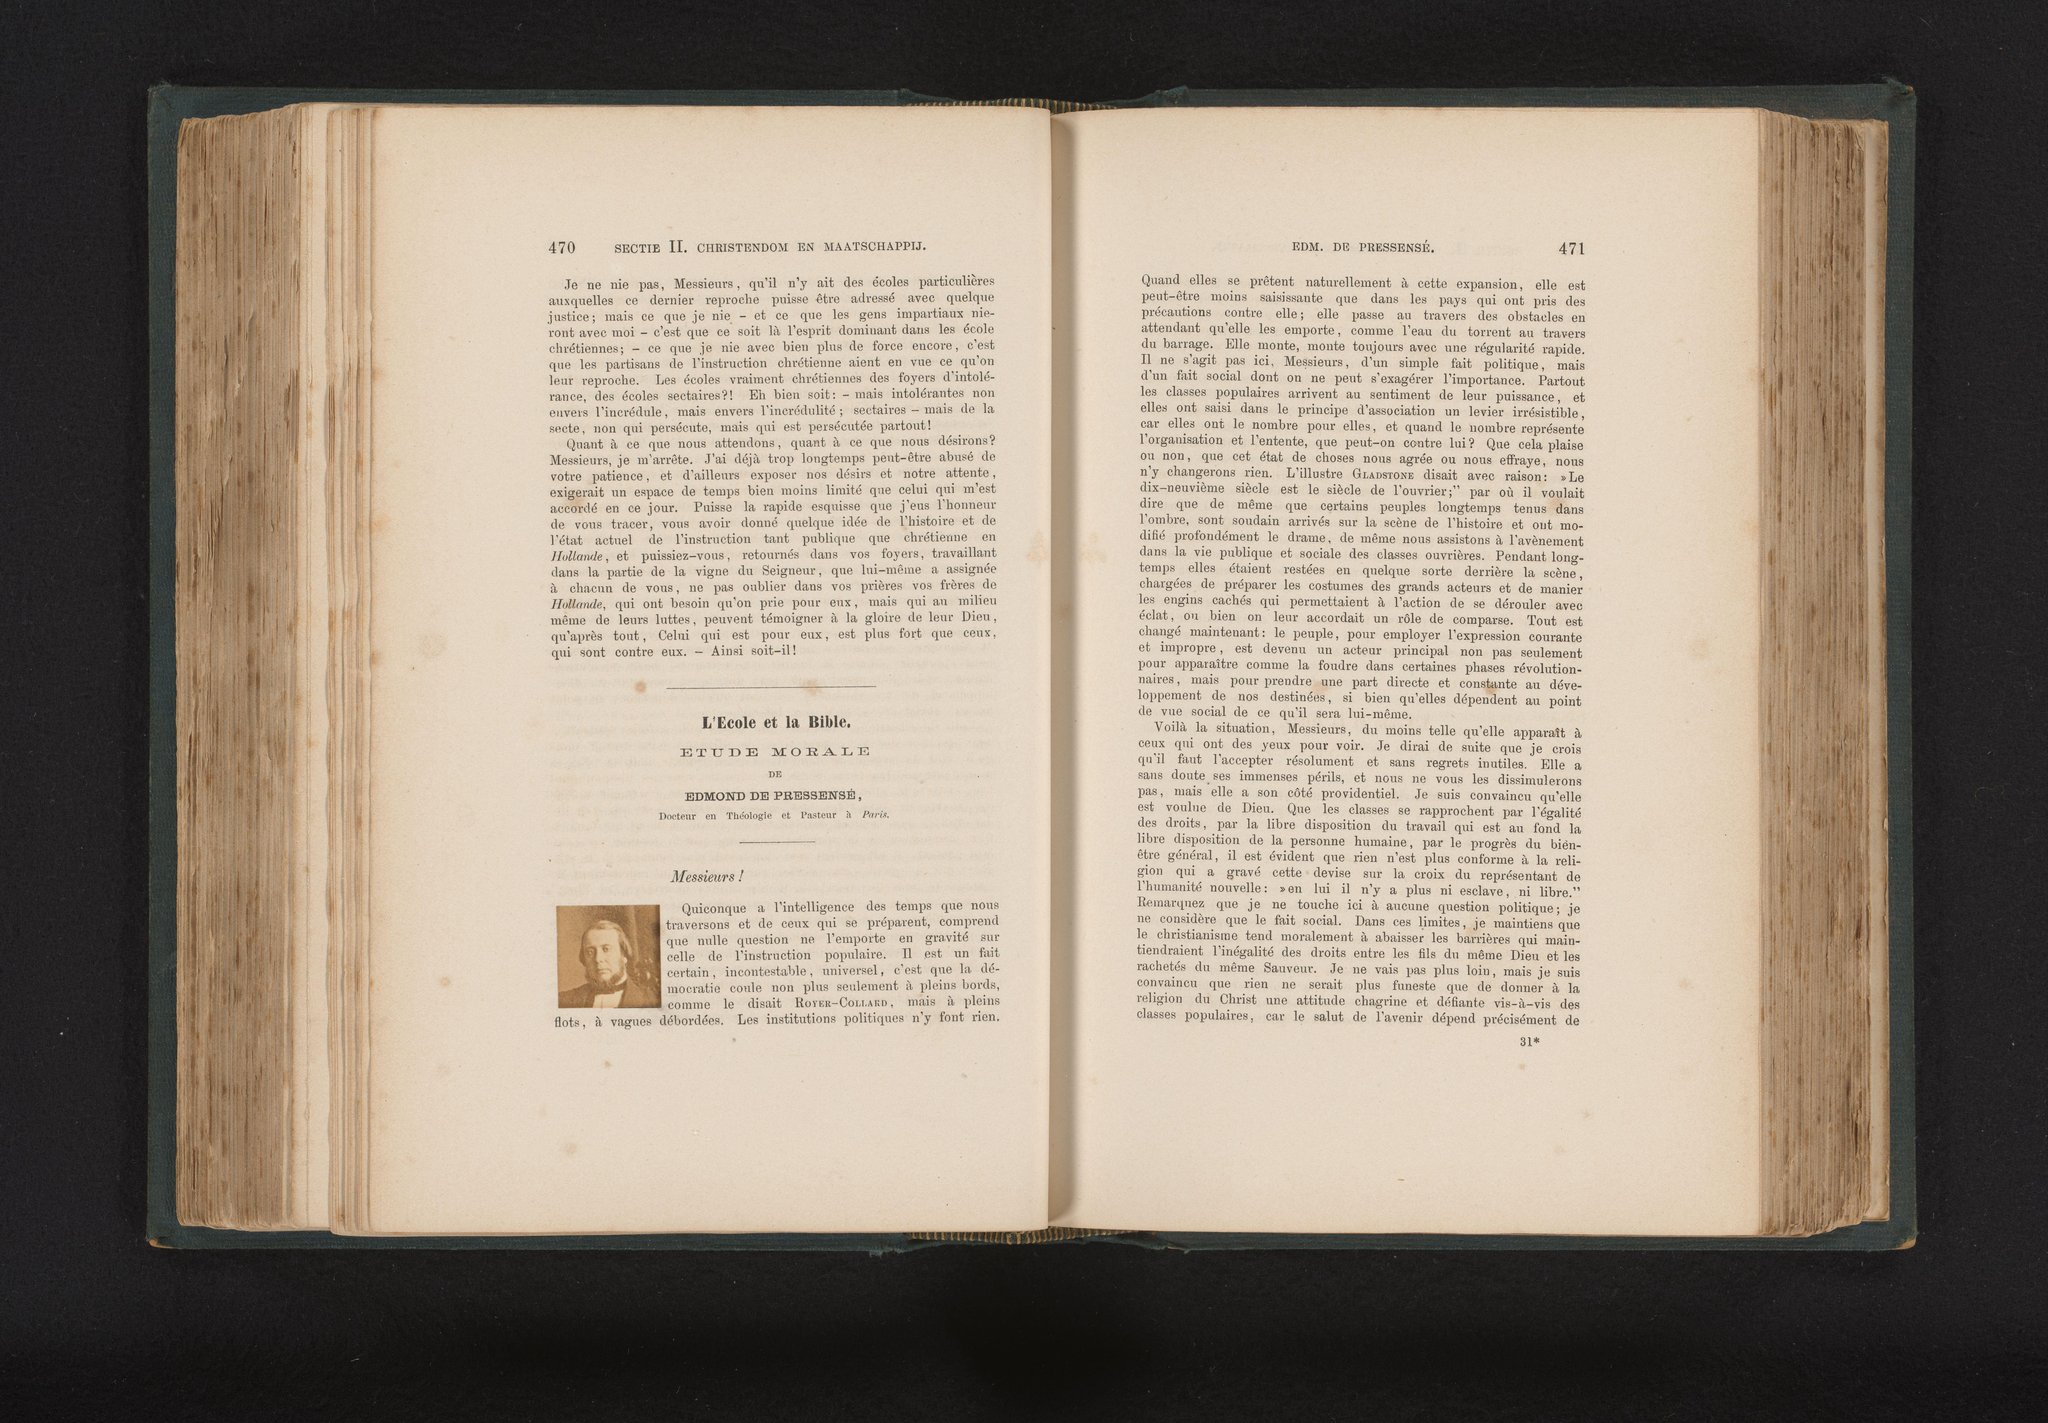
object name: page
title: Portret van Edmond de Pressensé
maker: Anonymous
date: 1855-1867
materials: paper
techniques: albumen print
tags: historical persons